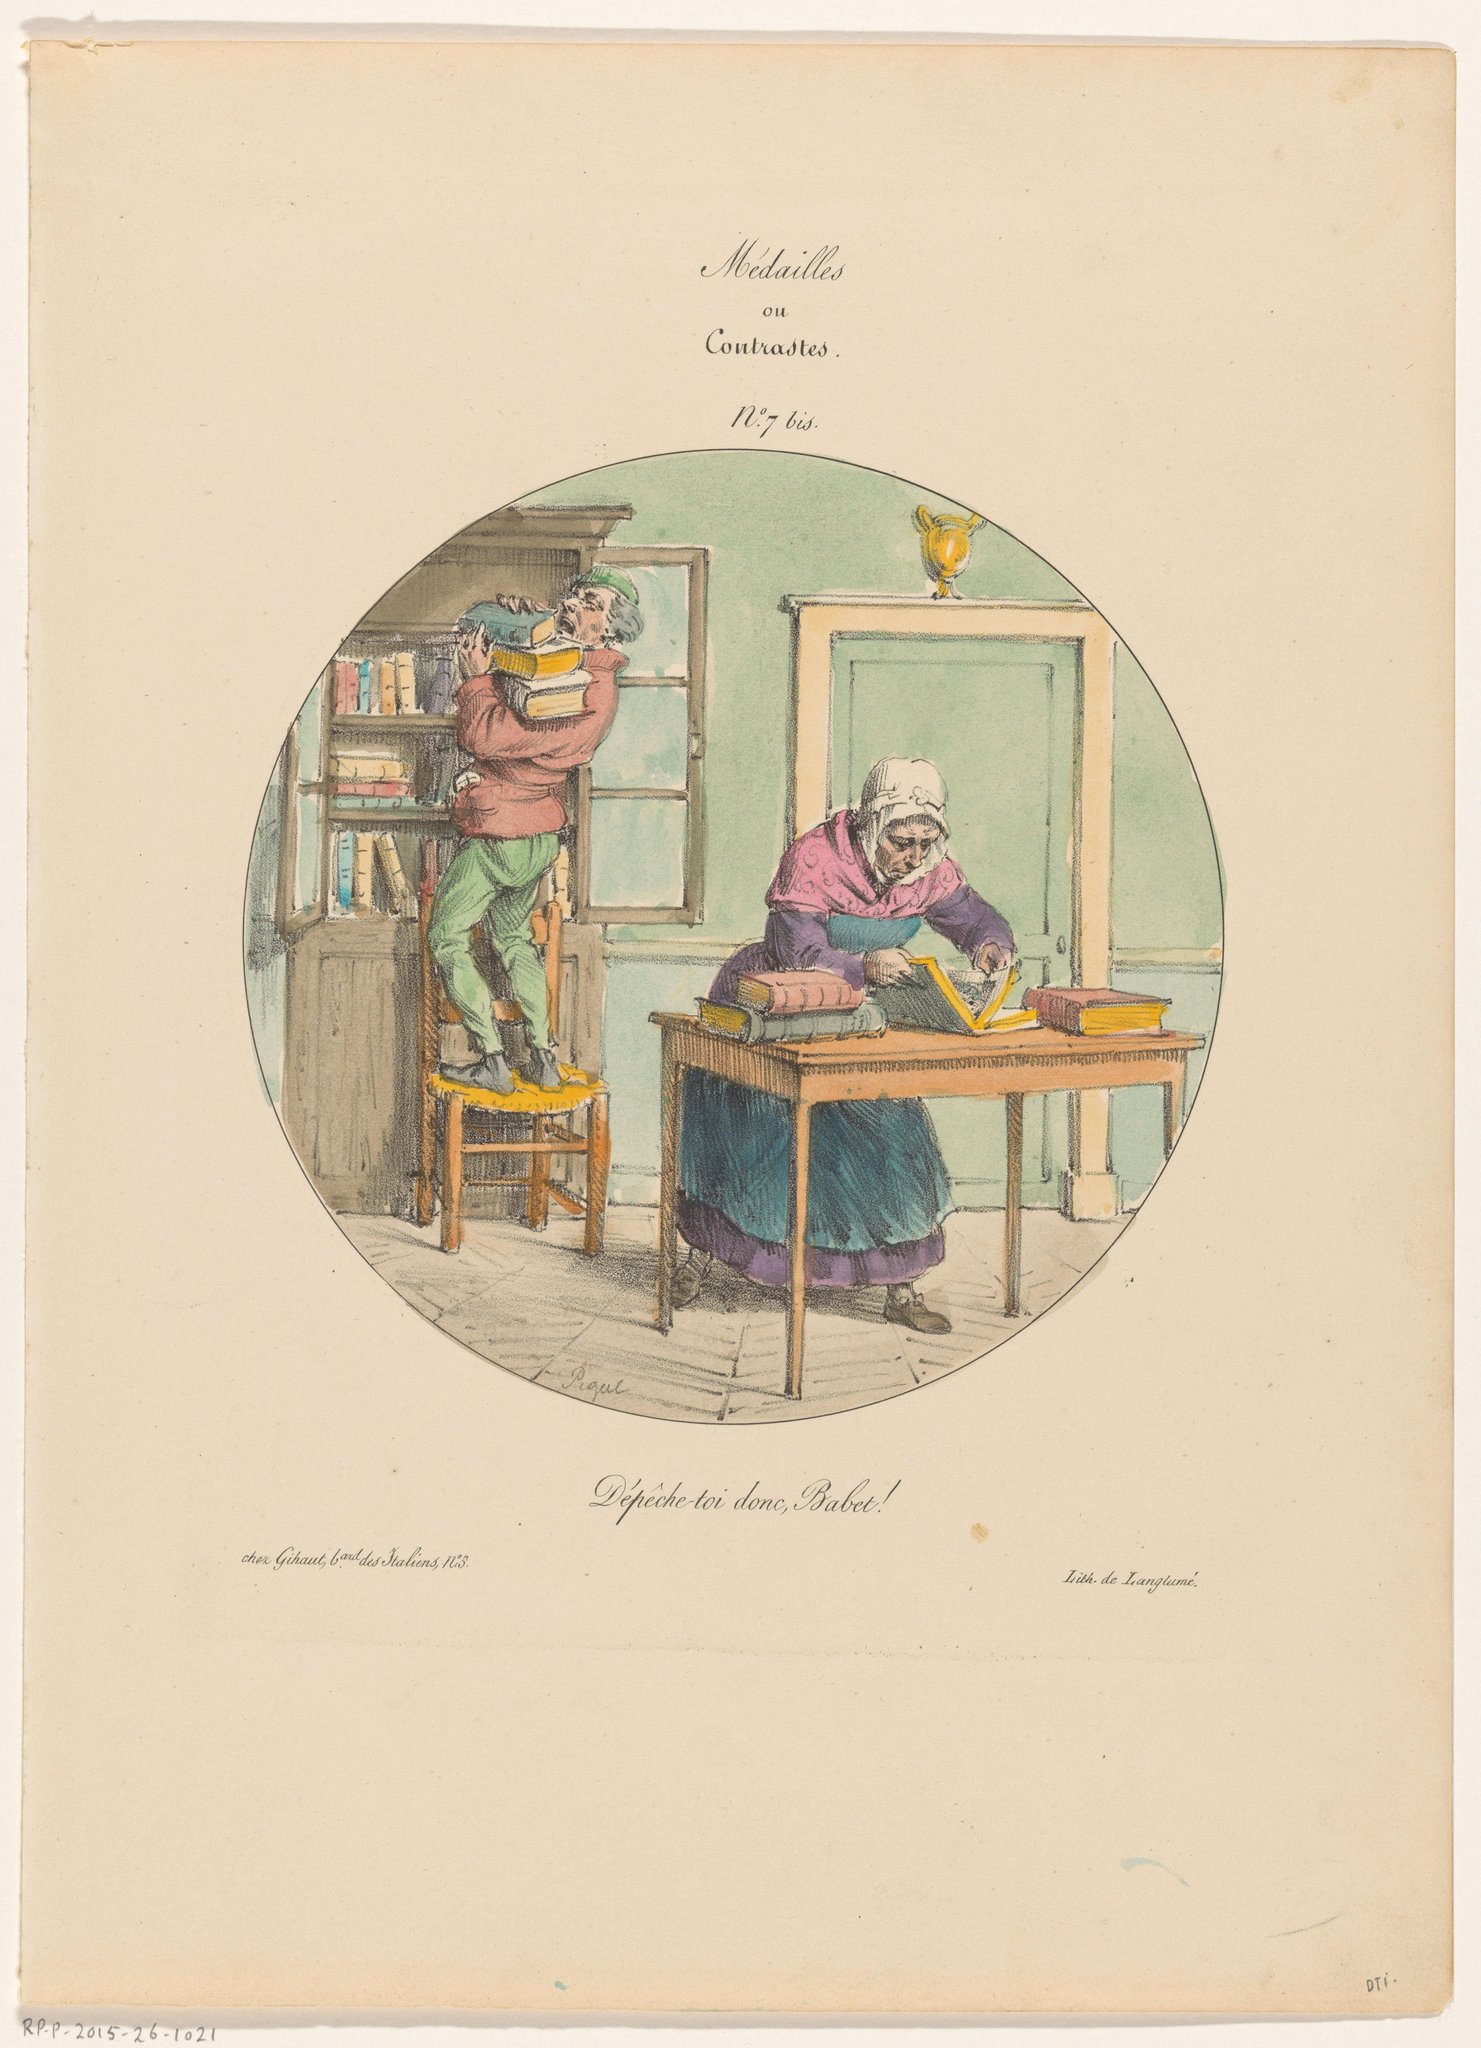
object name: print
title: Médailles ou contrastes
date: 1820-1830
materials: paper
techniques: hand coloring, lithograph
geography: paris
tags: bookshelves, book, political caricatures and satires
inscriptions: collector's mark: Lugt 4779, collector's mark: Lugt 2228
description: De man roept naar de vrouw die een boek doorbladert, staand achter een tafel.